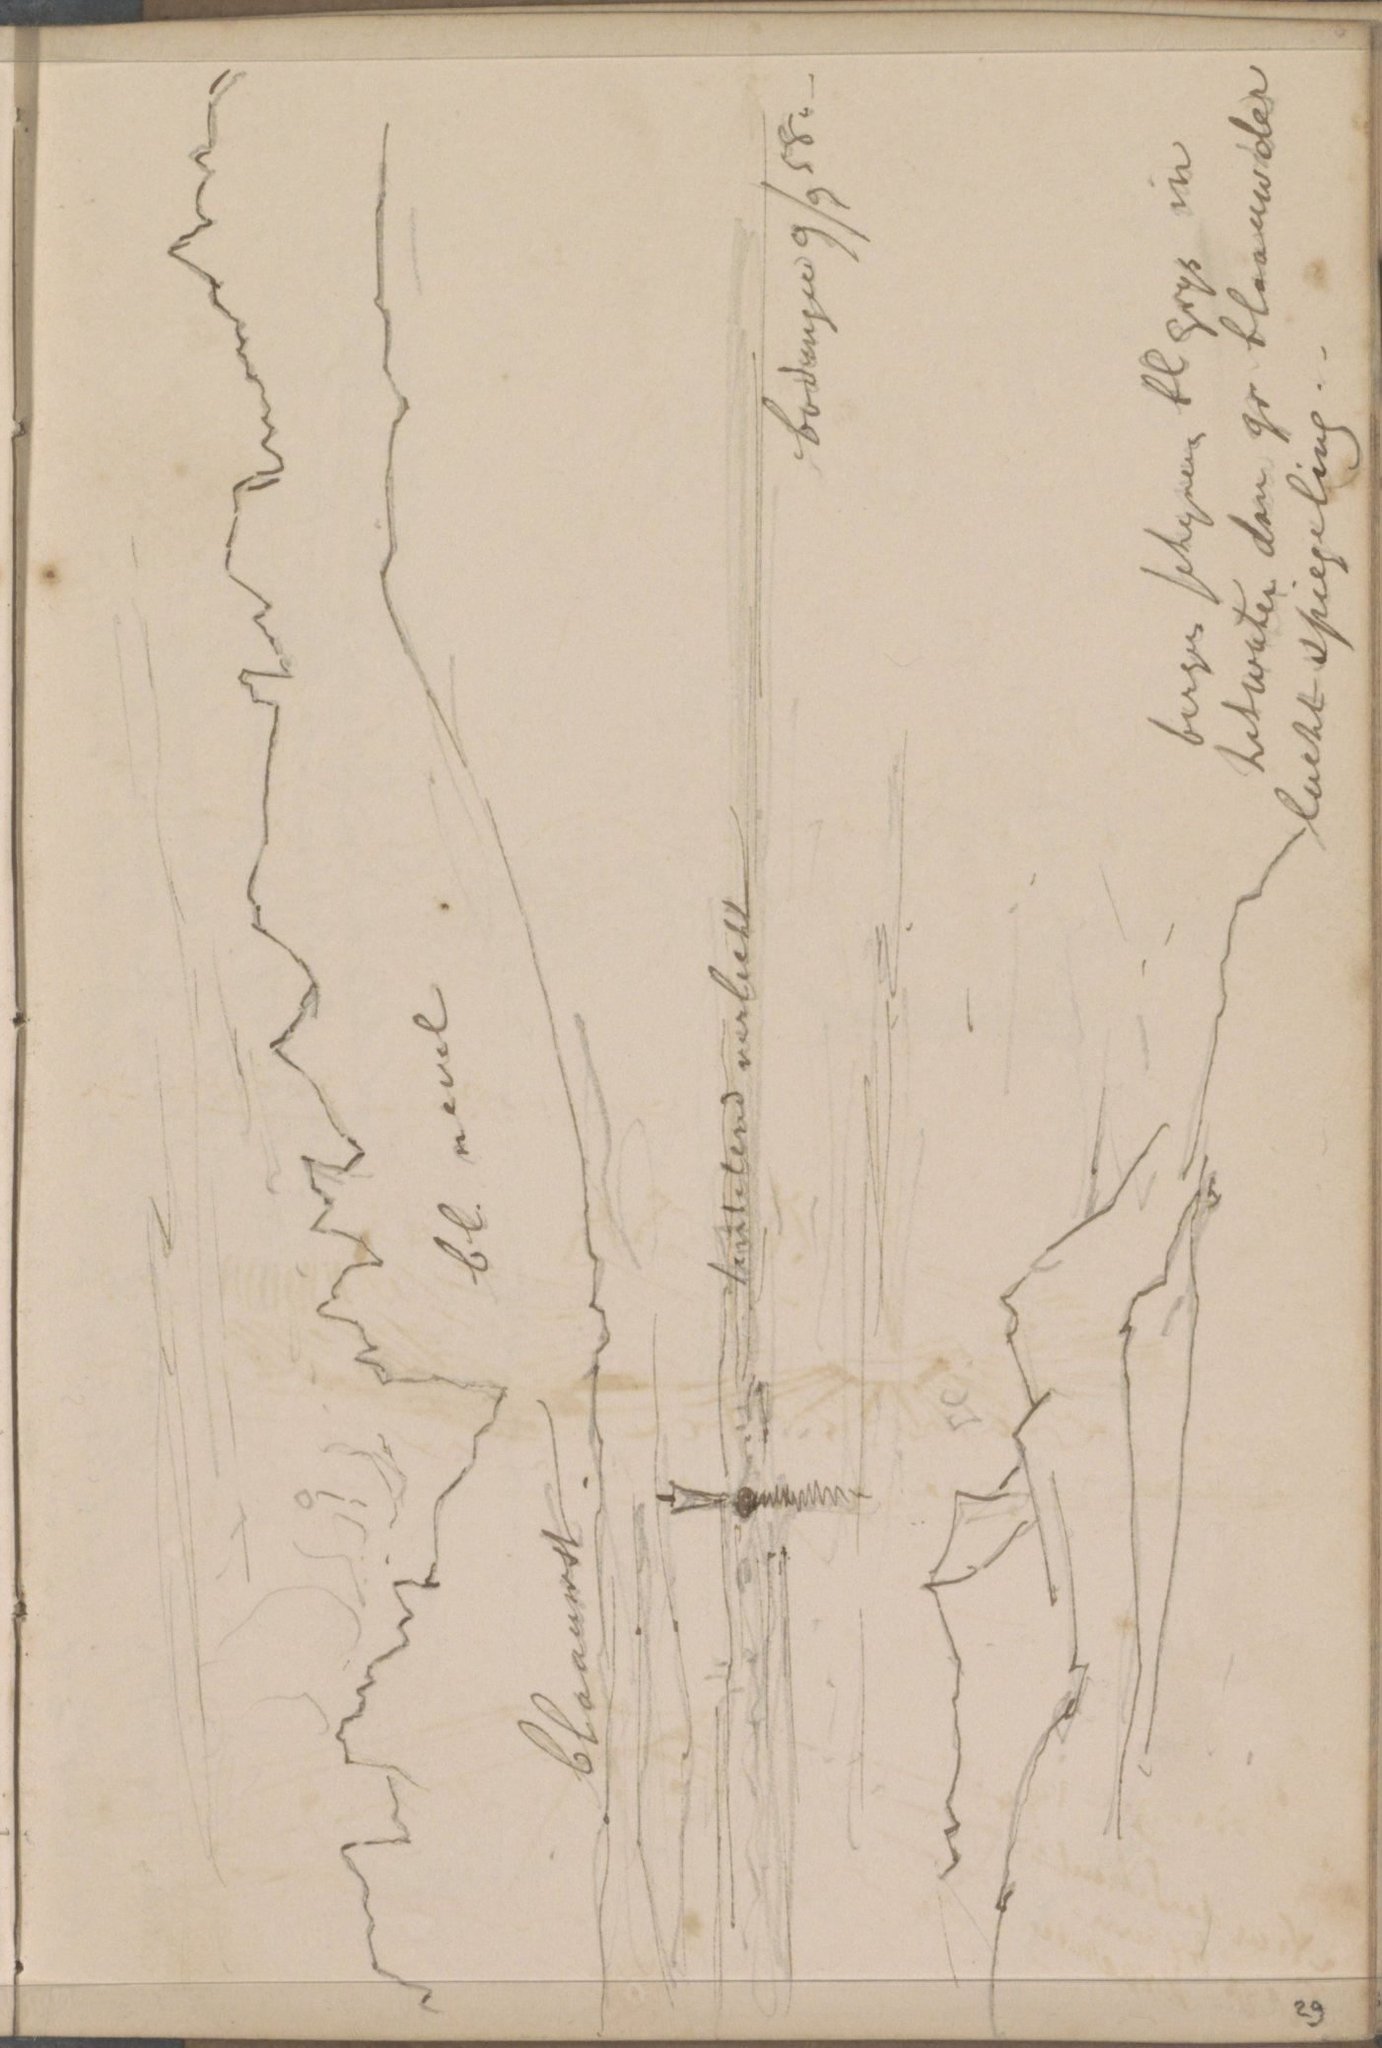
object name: sketchbook leaf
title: Gezicht op het Bodenmeer en omliggende bergen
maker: johannes tavenraat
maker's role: draughtsman, painter, print maker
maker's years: 1809-1881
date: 1809-1858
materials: ink, paper, pencil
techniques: pen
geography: lake constance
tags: lake, mountains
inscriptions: date and inscription: ‘Bodenzee 9/9 58’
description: Blad 29 recto uit een schetsboek met 47 bladen.